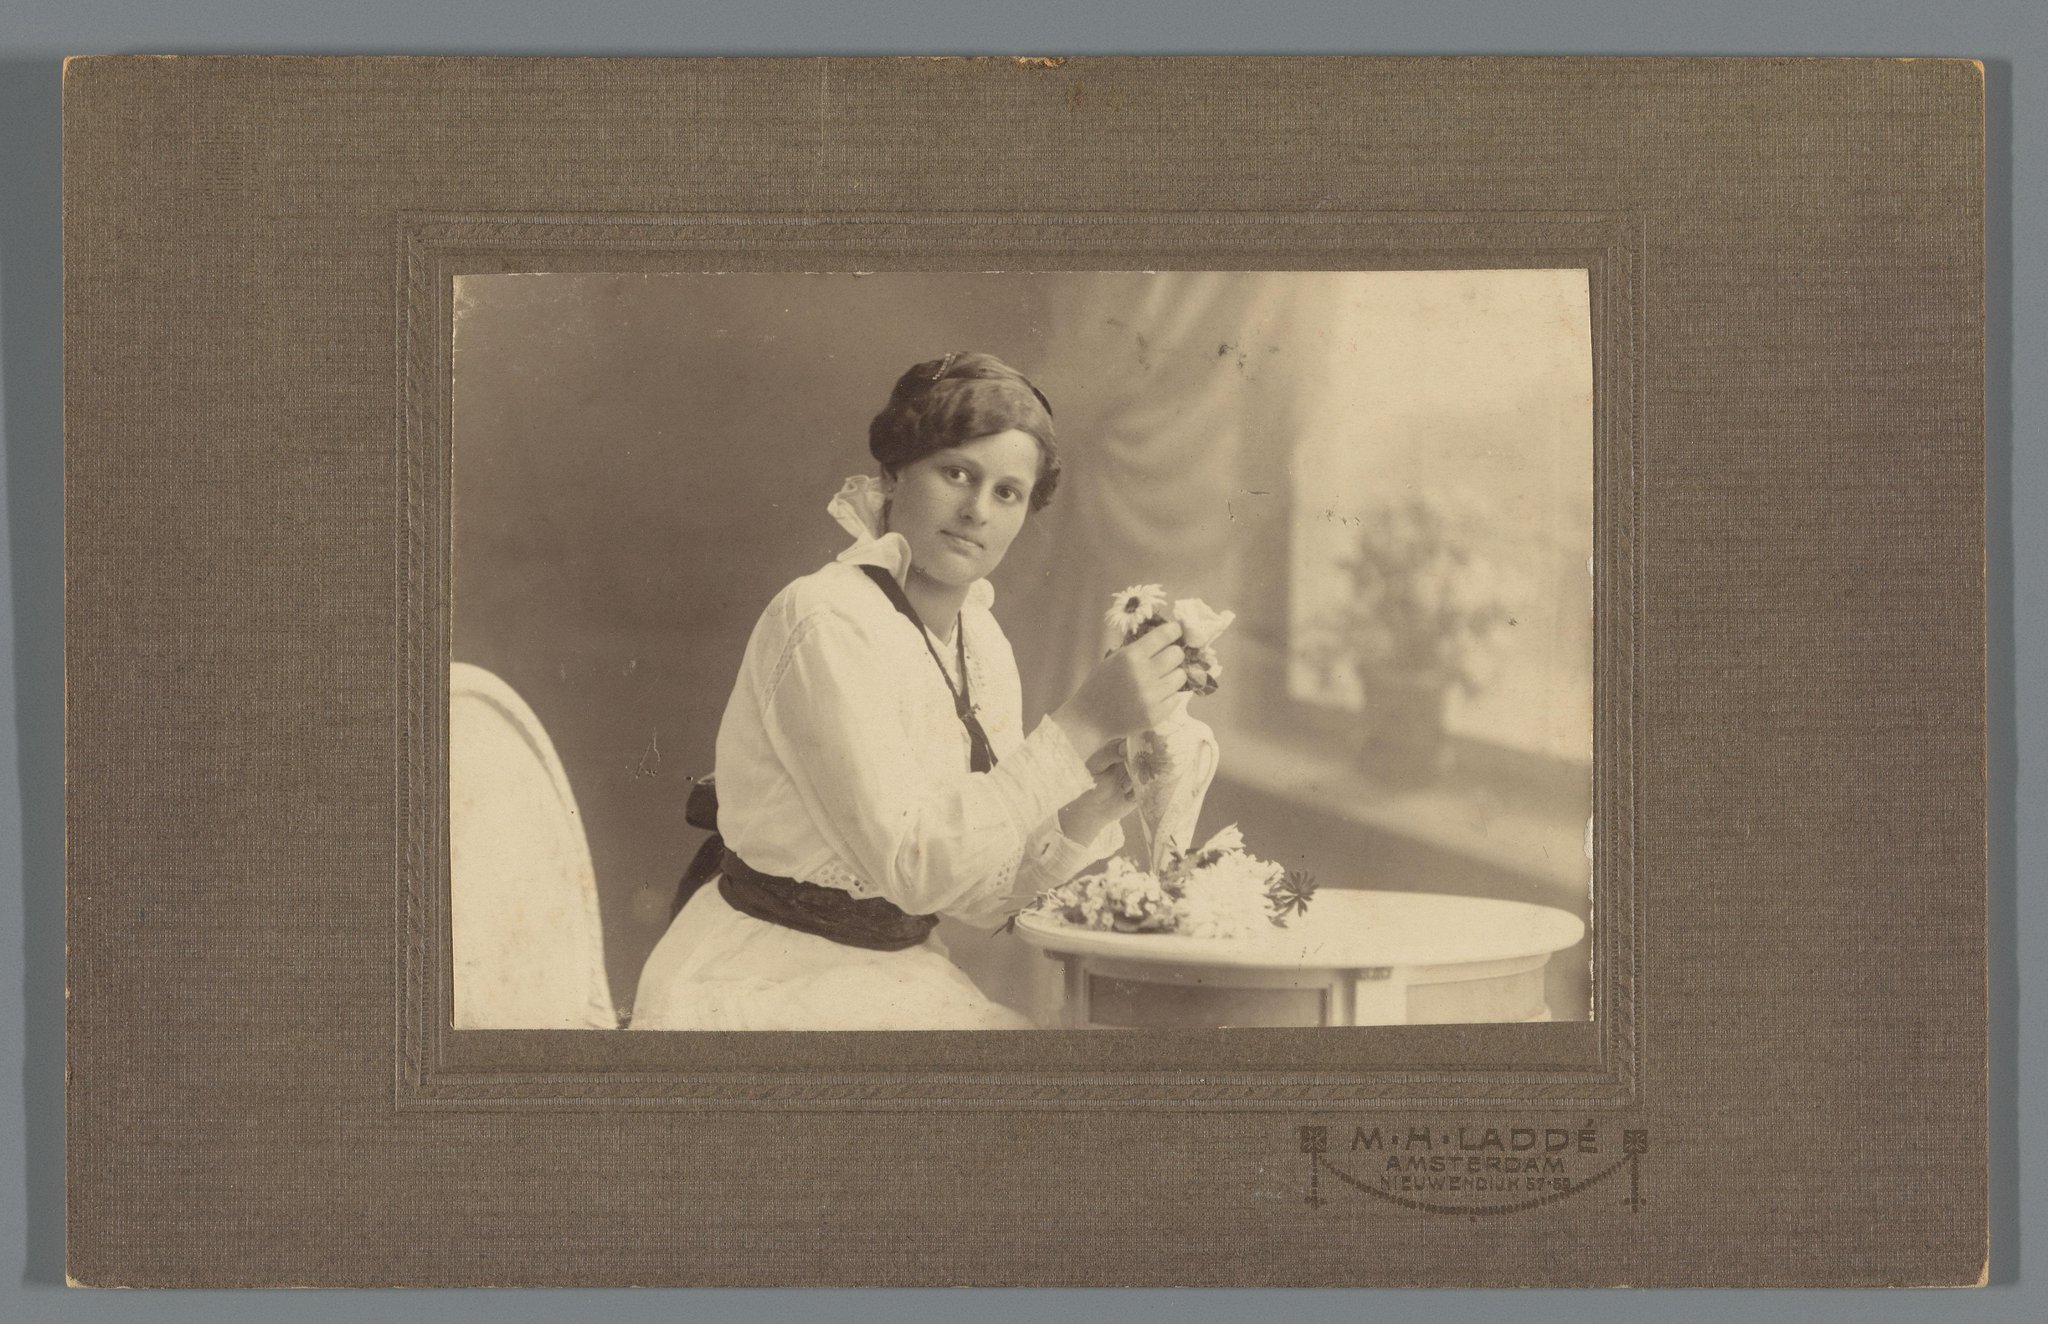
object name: photograph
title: Portret van een vrouw, aangeduid als Catrien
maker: machiel hendricus laddé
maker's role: fotograaf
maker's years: 1866-1932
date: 1892-1906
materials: paper, cardboard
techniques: gelatin silver print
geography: amsterdam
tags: anonymous historical person portrayed - bb - woman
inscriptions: inscription: ‘Catrien/ 61741/ Lust [?]’, address: ‘AMSTERDAM/ NIEUWENDIJK 57-59’